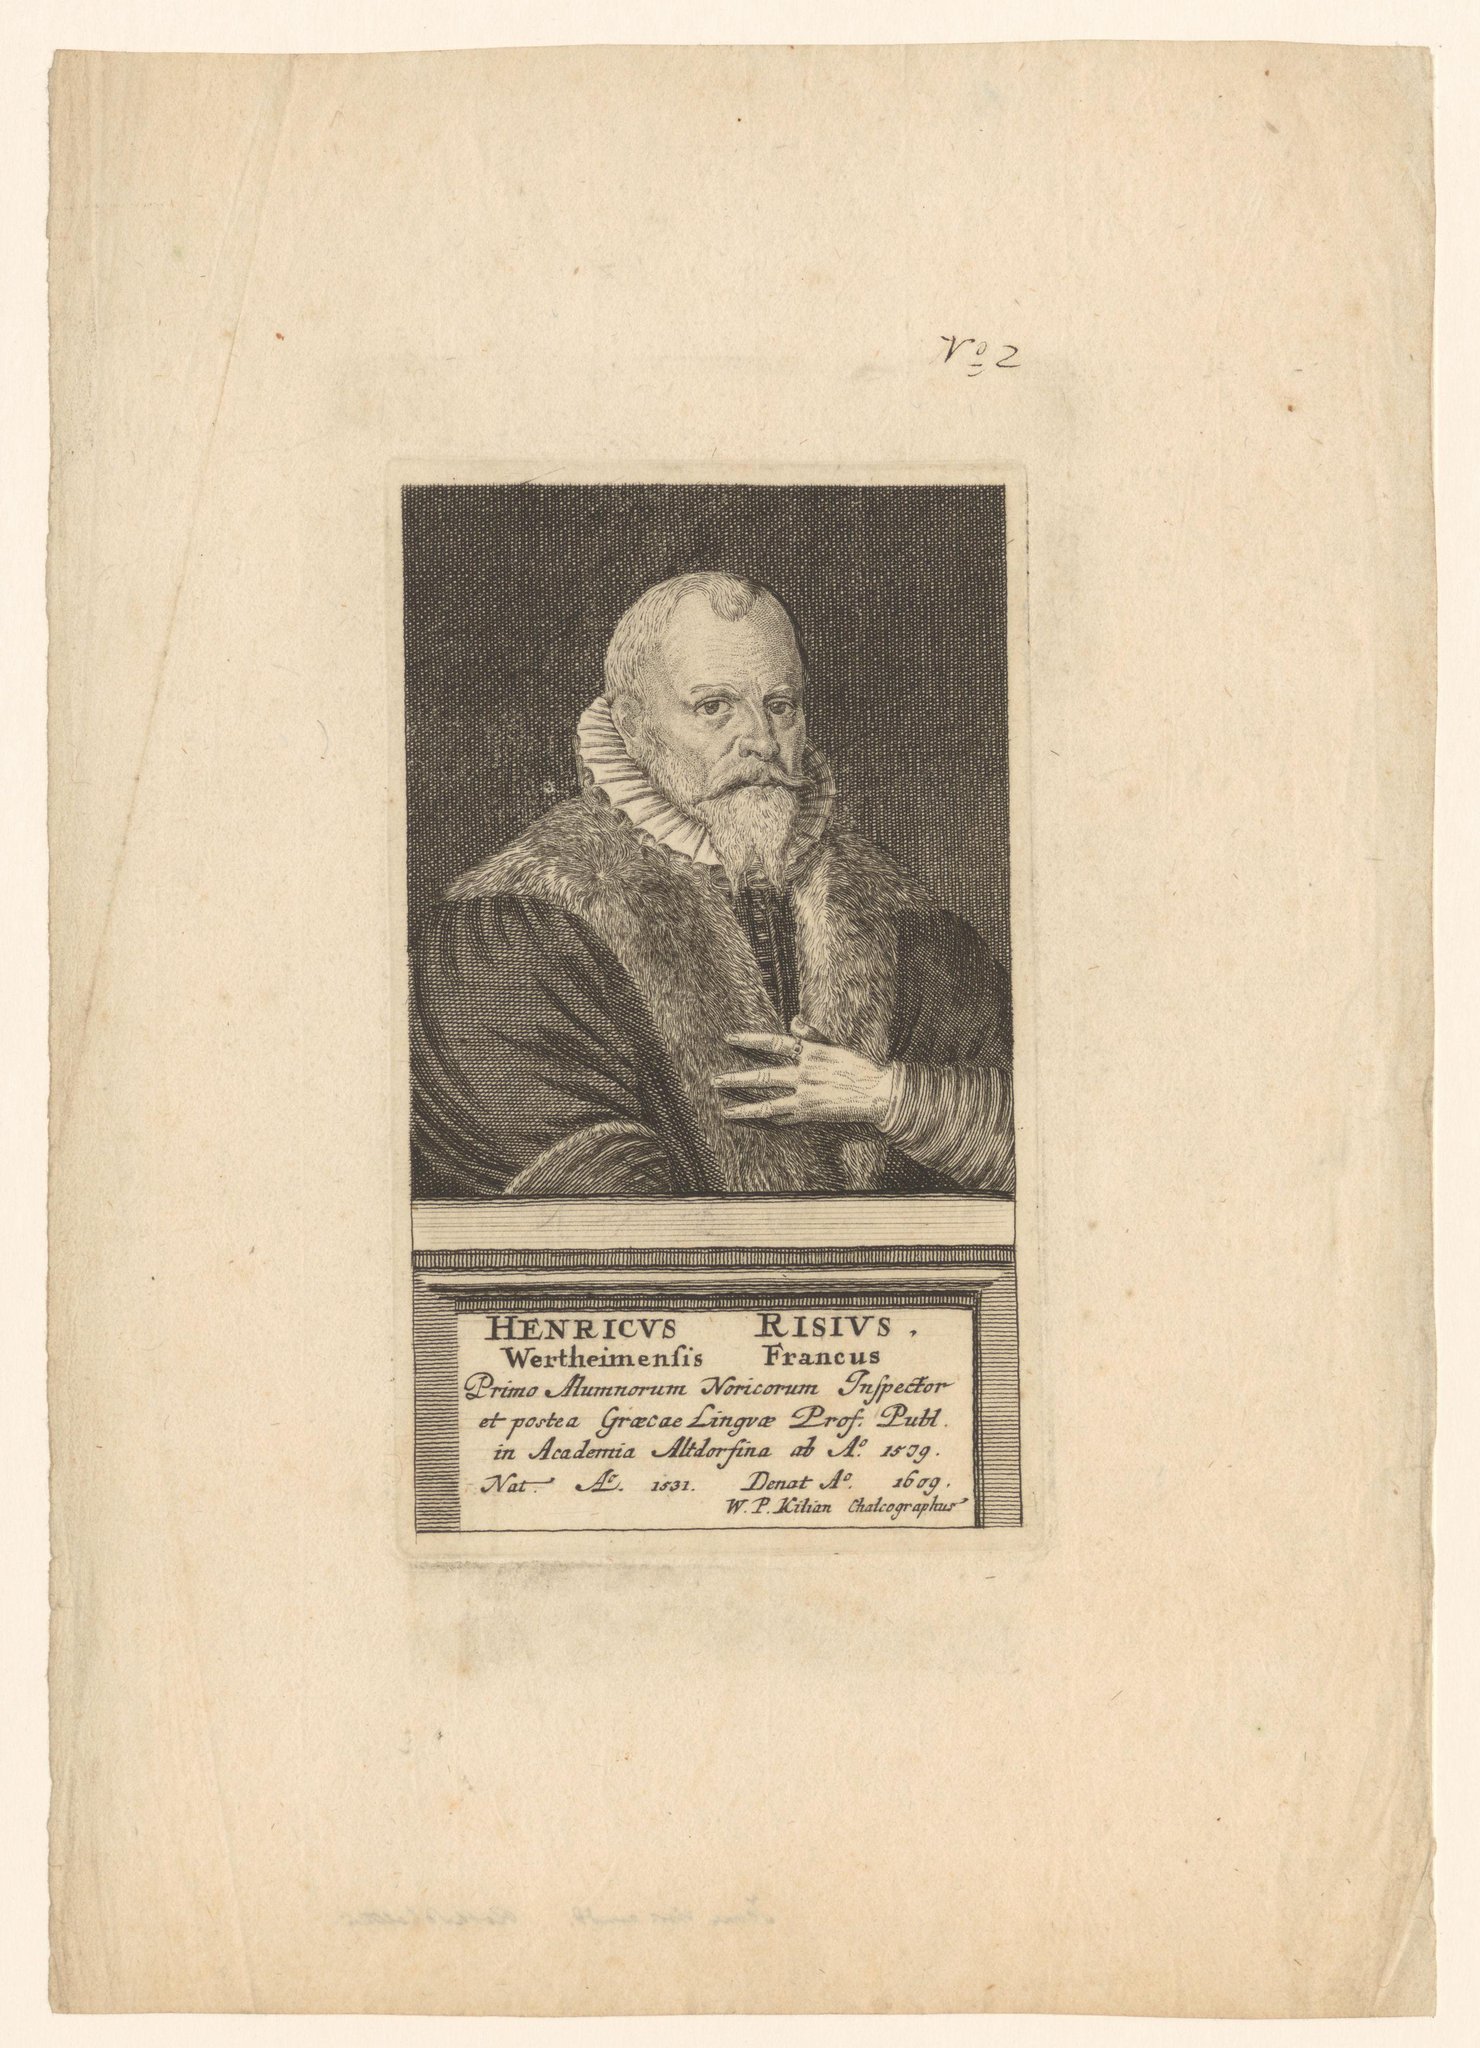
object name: print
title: Portret van Heinrich Risius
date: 1669-1728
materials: paper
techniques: engraving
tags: further education (+ portrait of teacher, professor), historical persons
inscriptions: collector's mark: Lugt 2228